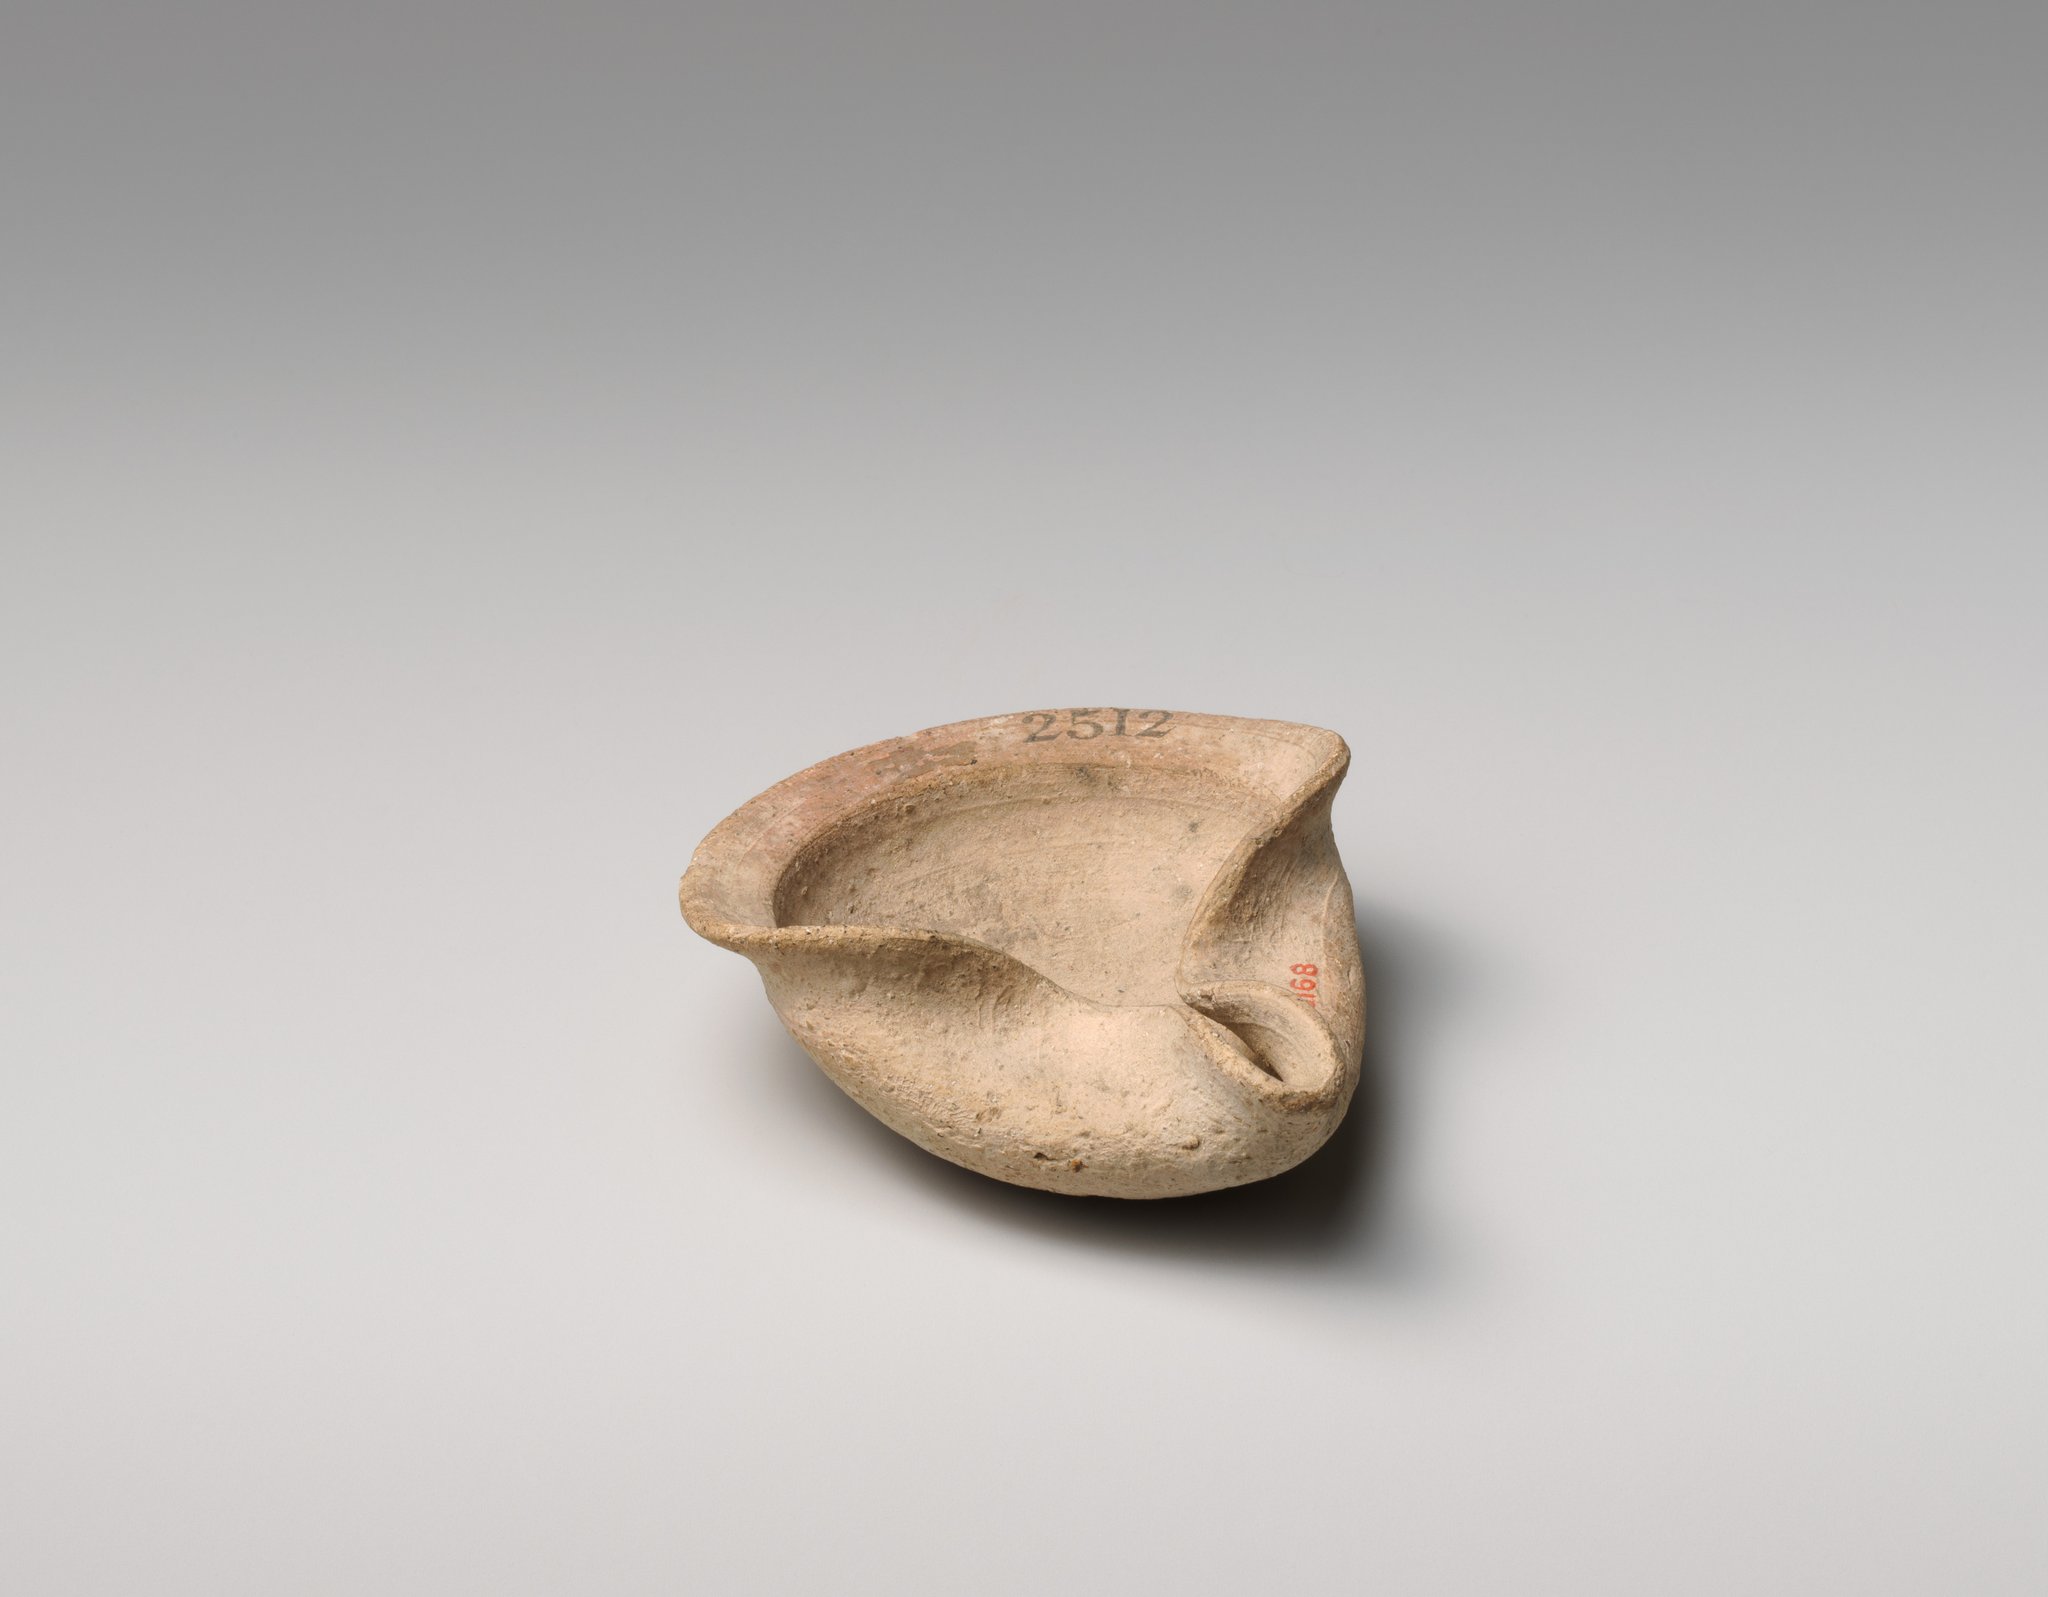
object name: lamp, saucer shaped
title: Terracotta saucer-shaped lamp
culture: cypriot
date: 400-301 BCE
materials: terracotta